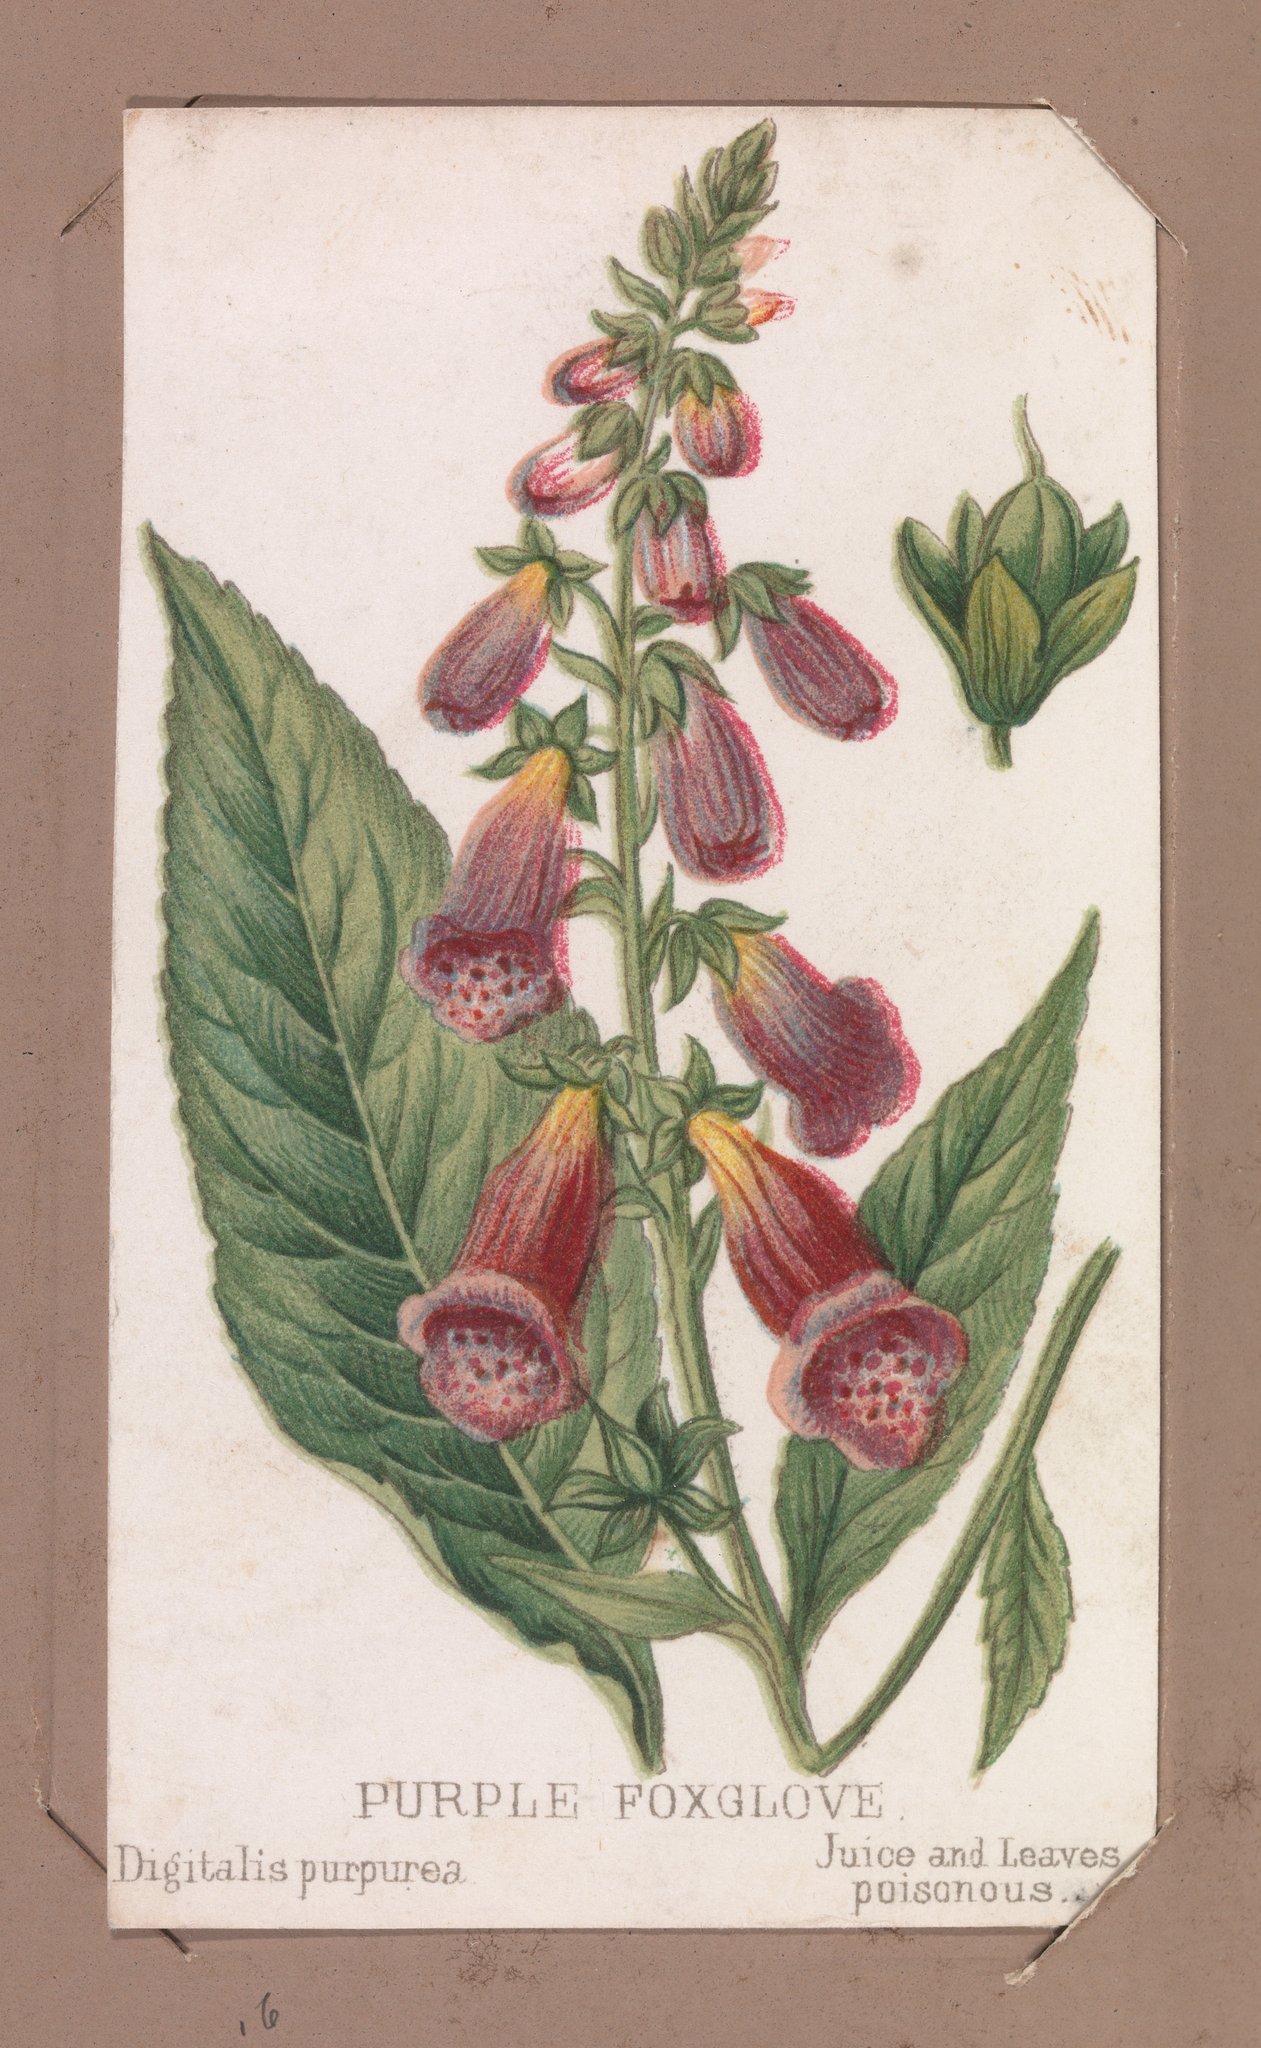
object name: album card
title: Purple Foxglove from the Plants series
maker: louis prang & co.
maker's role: publisher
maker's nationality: american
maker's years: 1800-1950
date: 1862-1869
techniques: lithograph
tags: plants